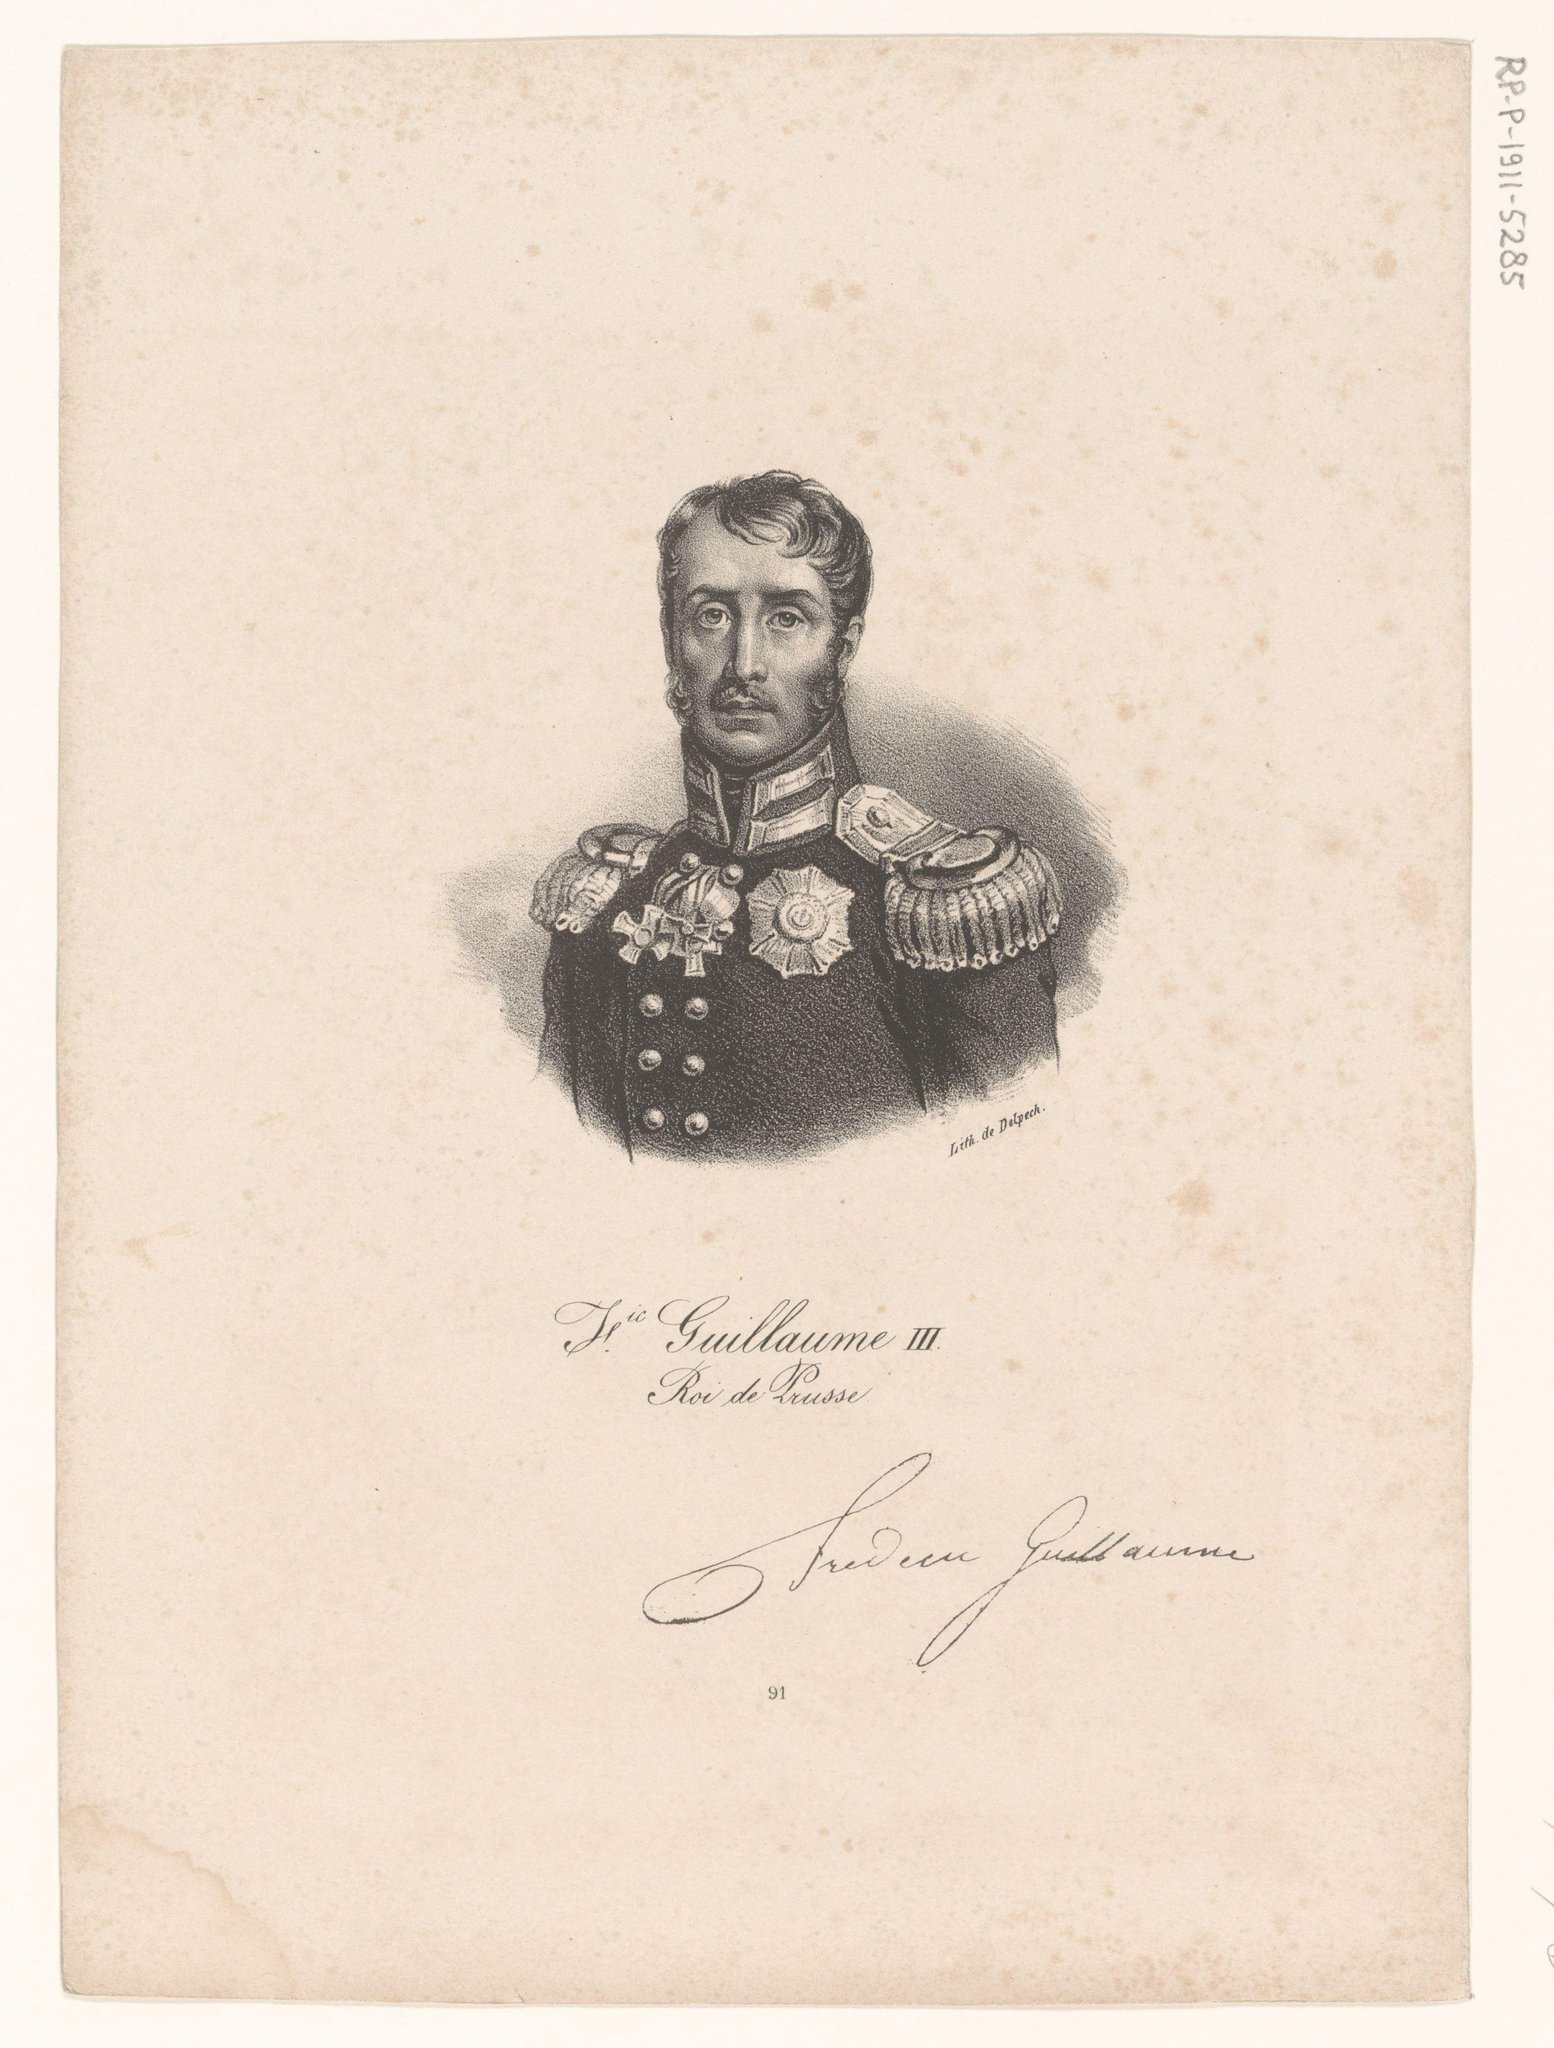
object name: print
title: Portret van Frederik Willem III van Pruisen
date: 1818-1842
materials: paper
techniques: lithograph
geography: paris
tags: berlin, frederik willem iii koning van pruisen, historical persons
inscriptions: collector's mark: Lugt 2228a